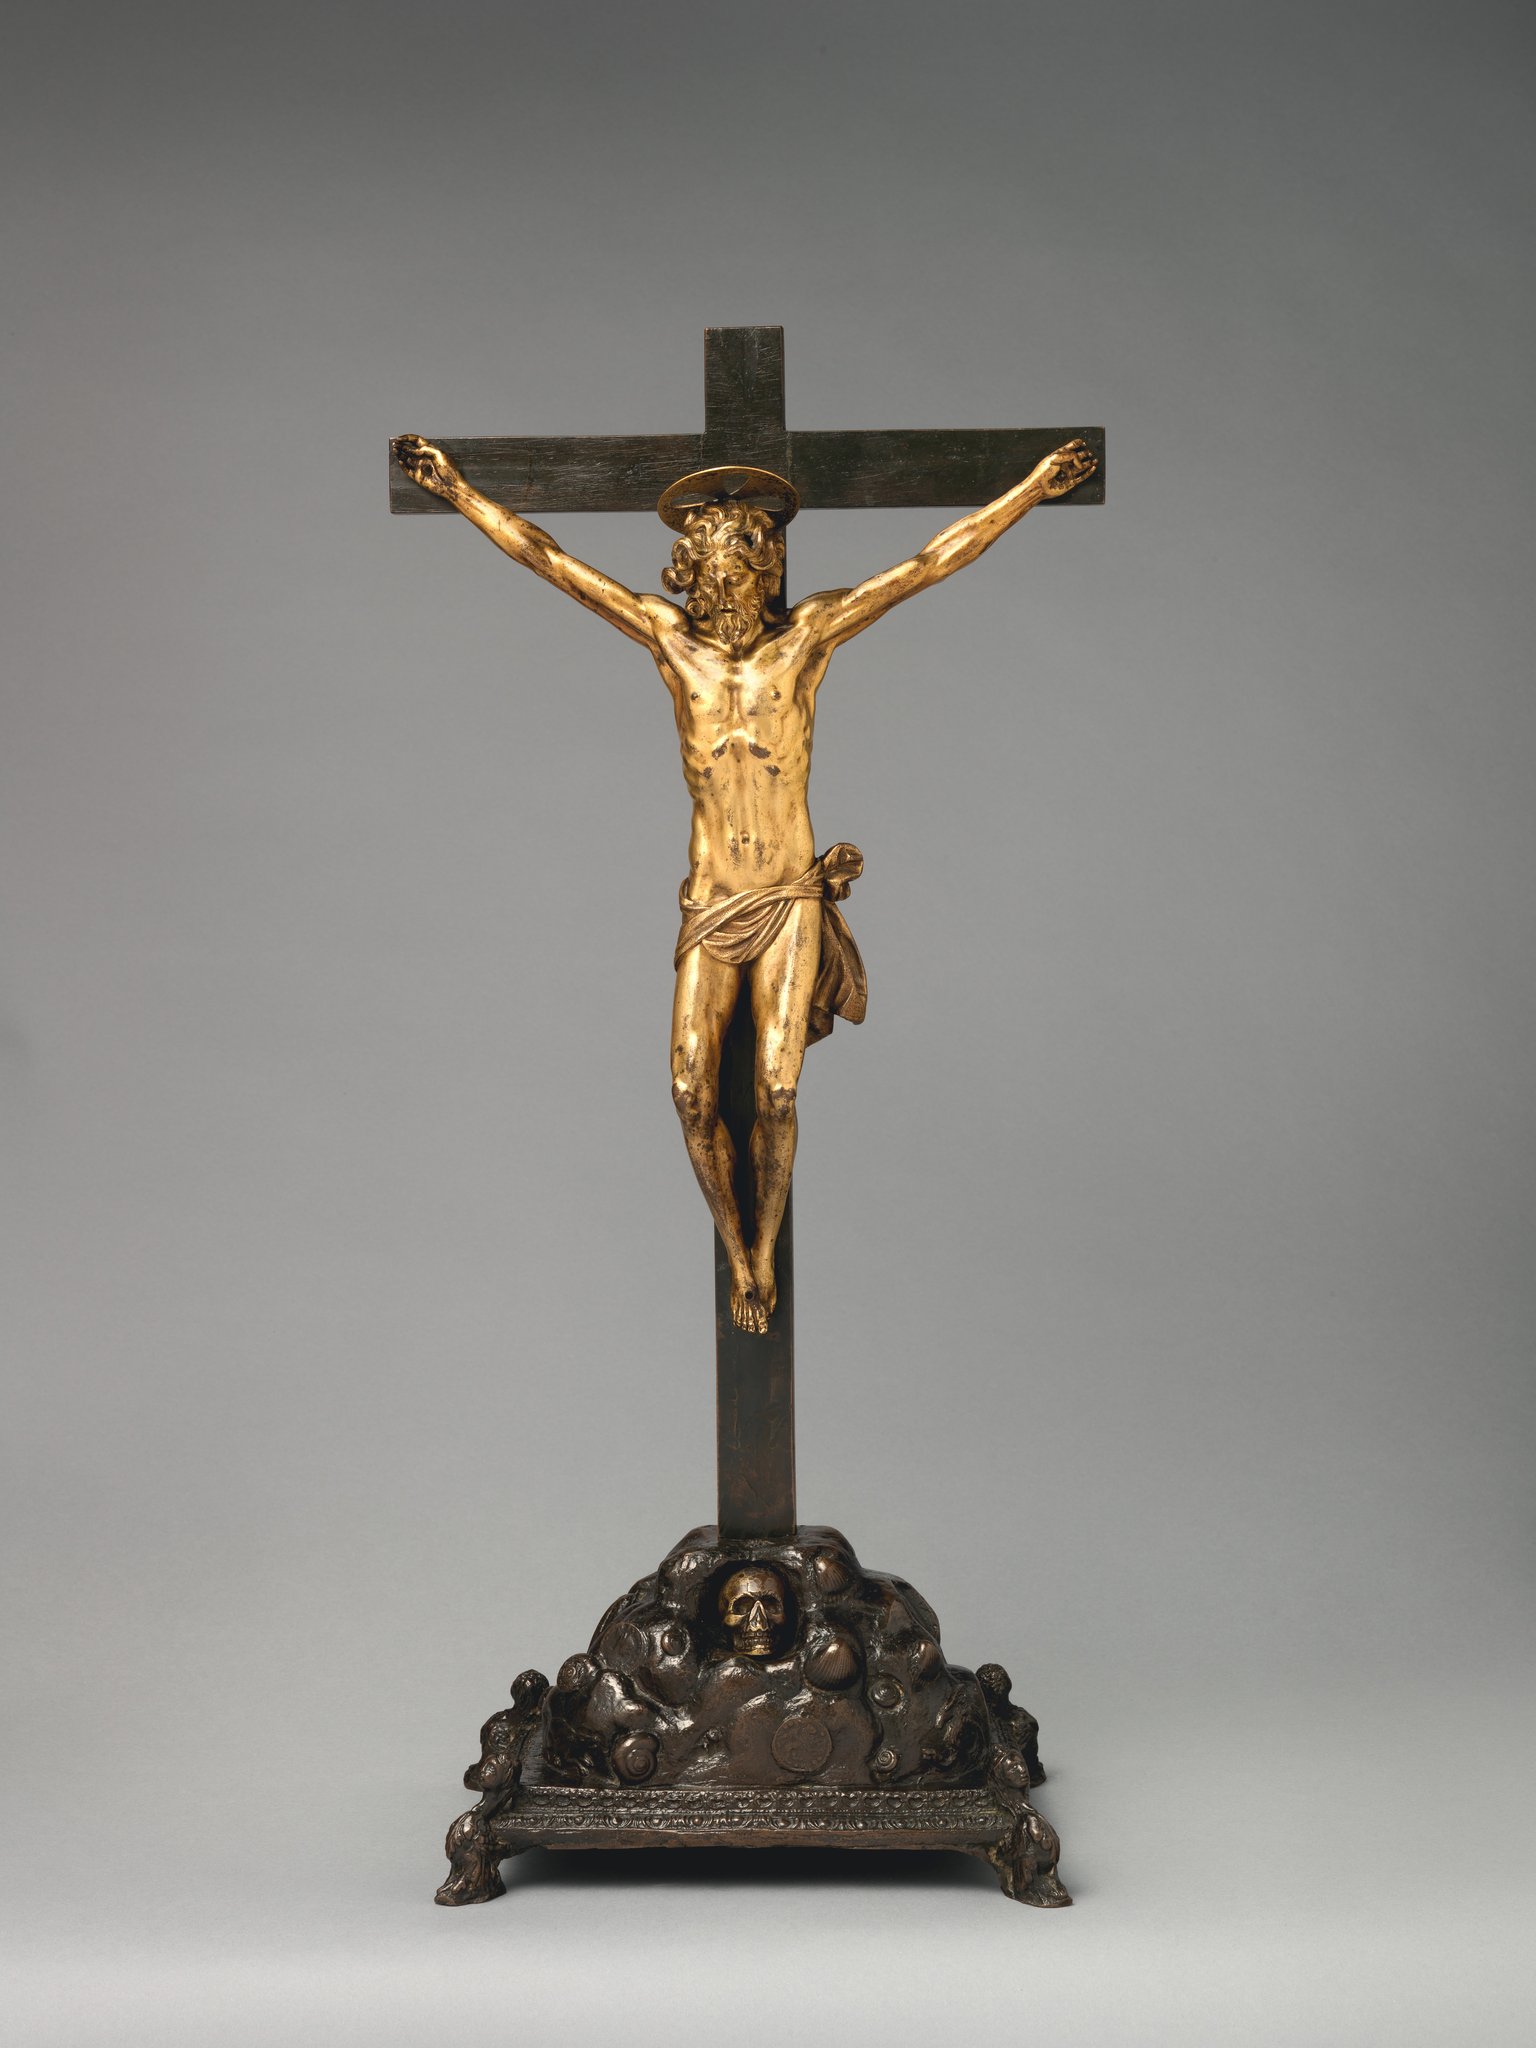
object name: statuette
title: Crucifix on a Golgotha base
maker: giuseppe de' levi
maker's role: maker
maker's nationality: italian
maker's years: 1522-1614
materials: bronze, gilt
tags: skulls,snails,shells,christ,crucifixion